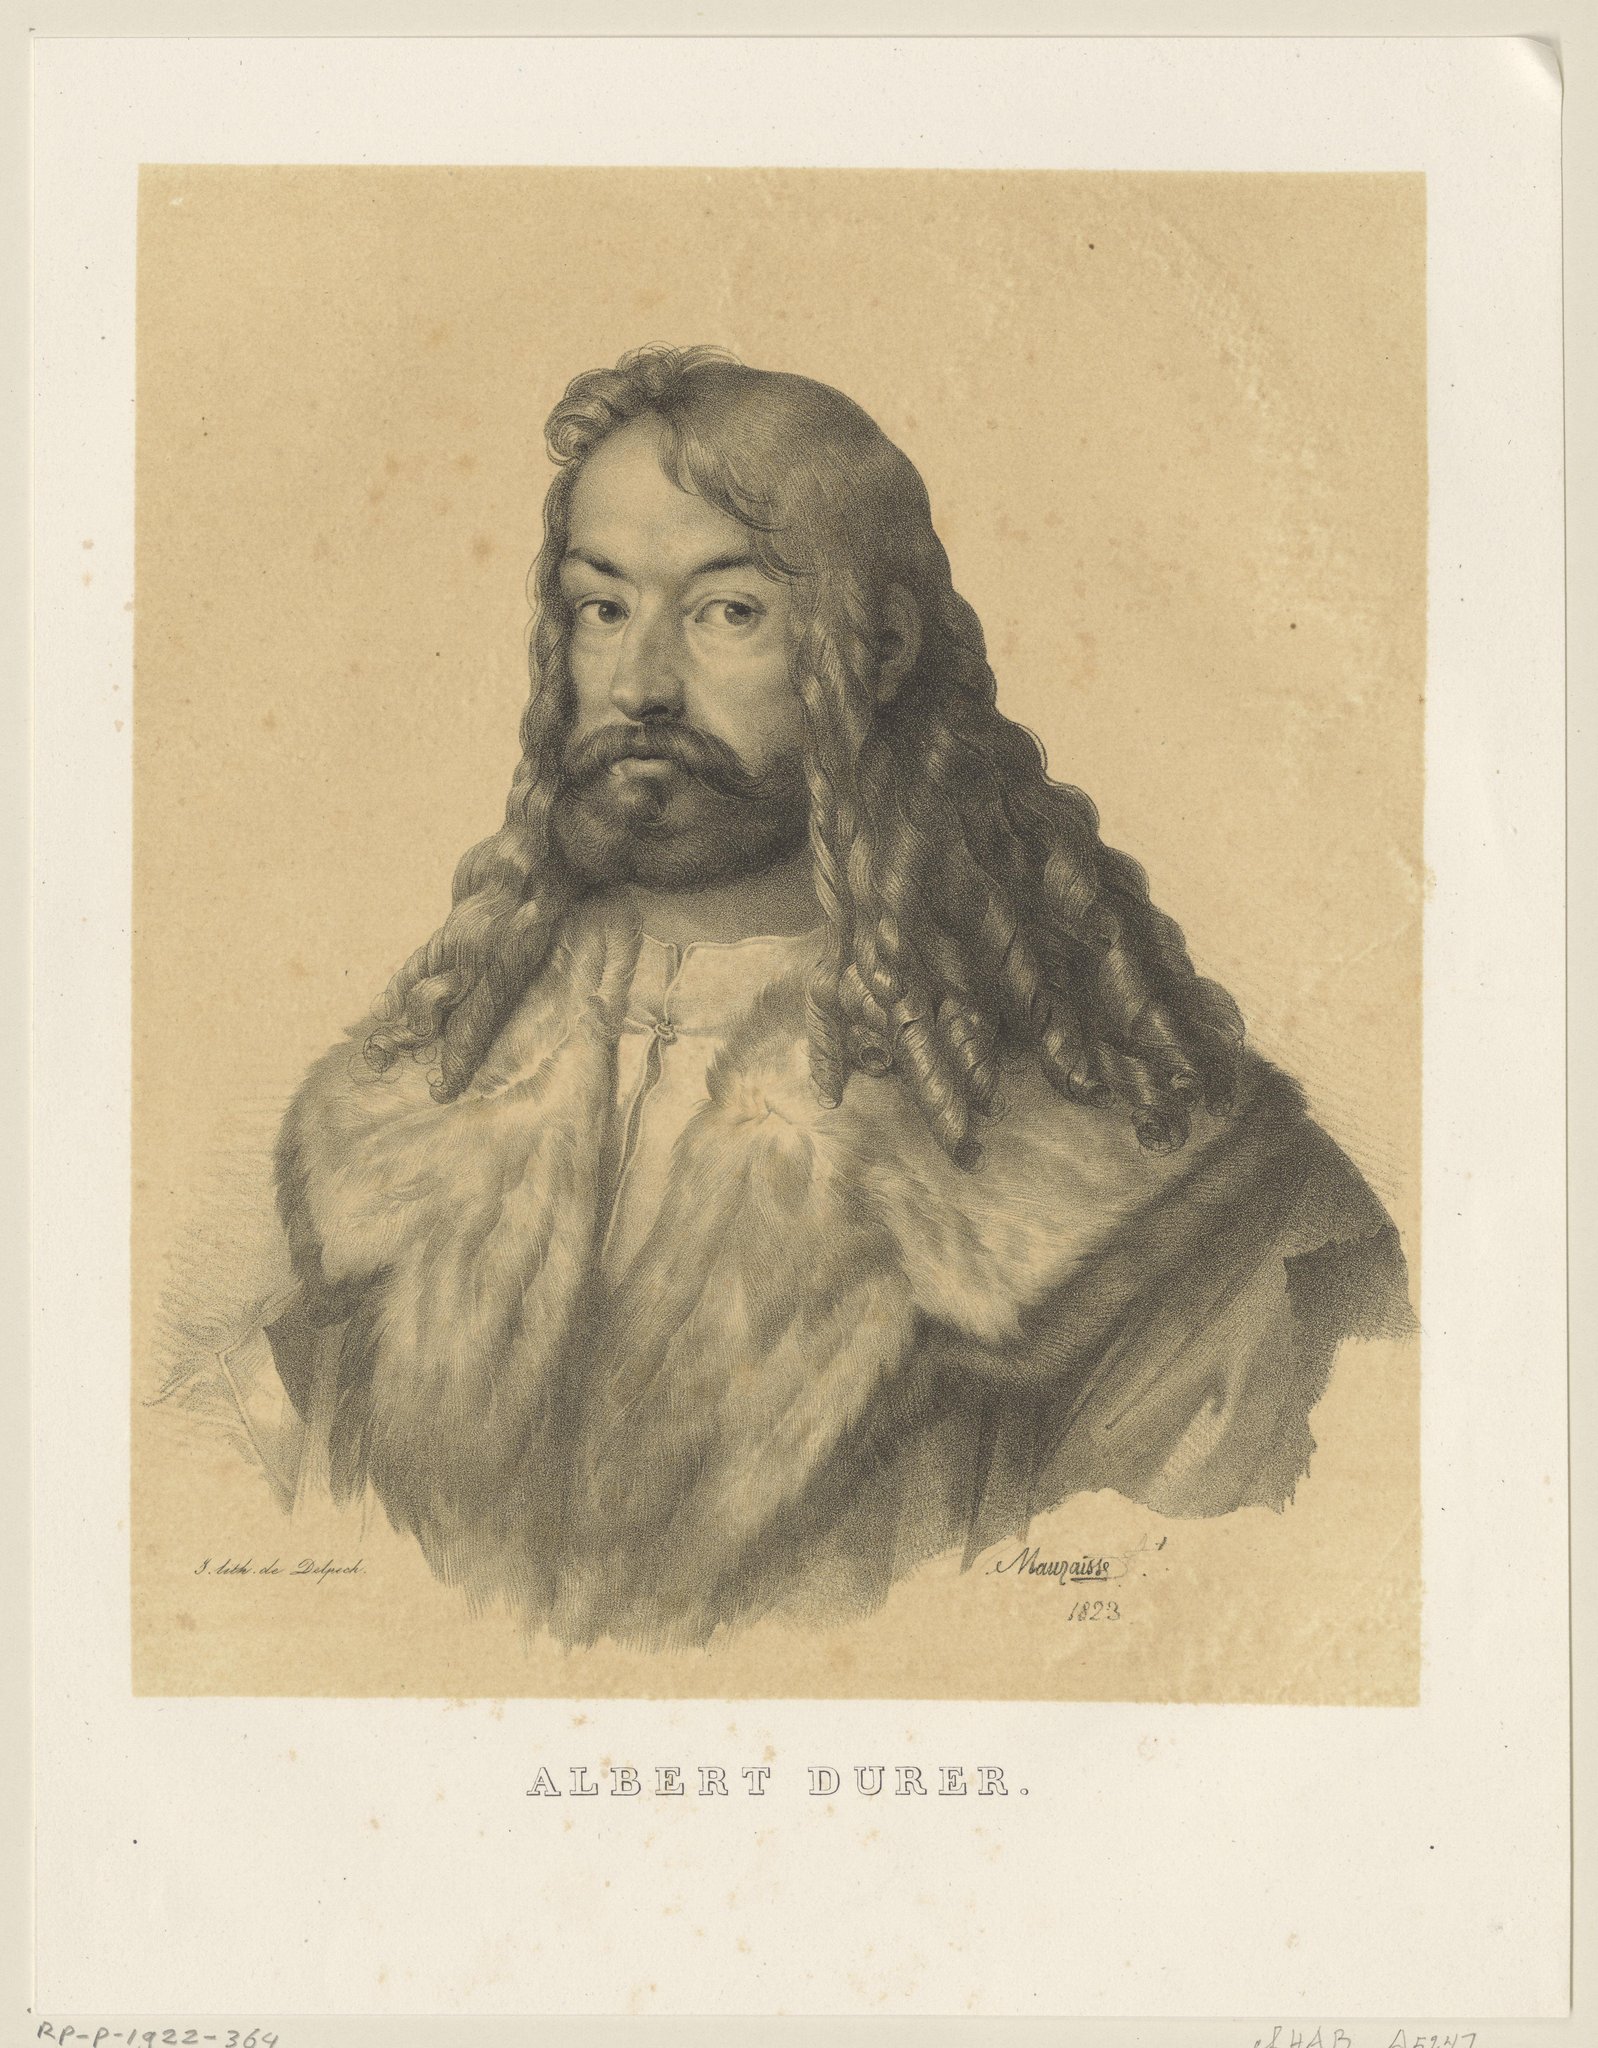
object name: print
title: Portret van Albrecht Dürer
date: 1823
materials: paper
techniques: tone lithography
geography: paris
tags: painter, albrecht dürer, historical persons, portrait, self-portrait of painter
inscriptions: collector's mark: Lugt 2233